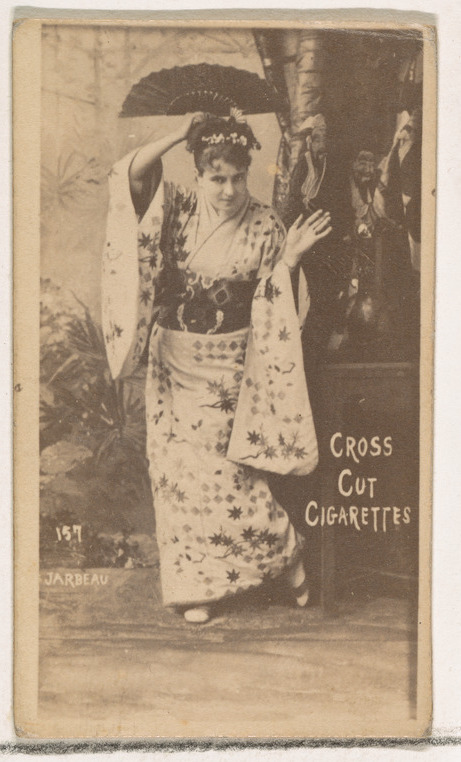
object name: print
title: Card Number 157, Jarbeau, from the Actors and Actresses series (N145-1) issued by Duke Sons & Co. to promote Cross Cut Cigarettes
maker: w. duke, sons & co.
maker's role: publisher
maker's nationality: american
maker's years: 1870-1920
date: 1880-1889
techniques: albumen silver print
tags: portraits,women,actresses